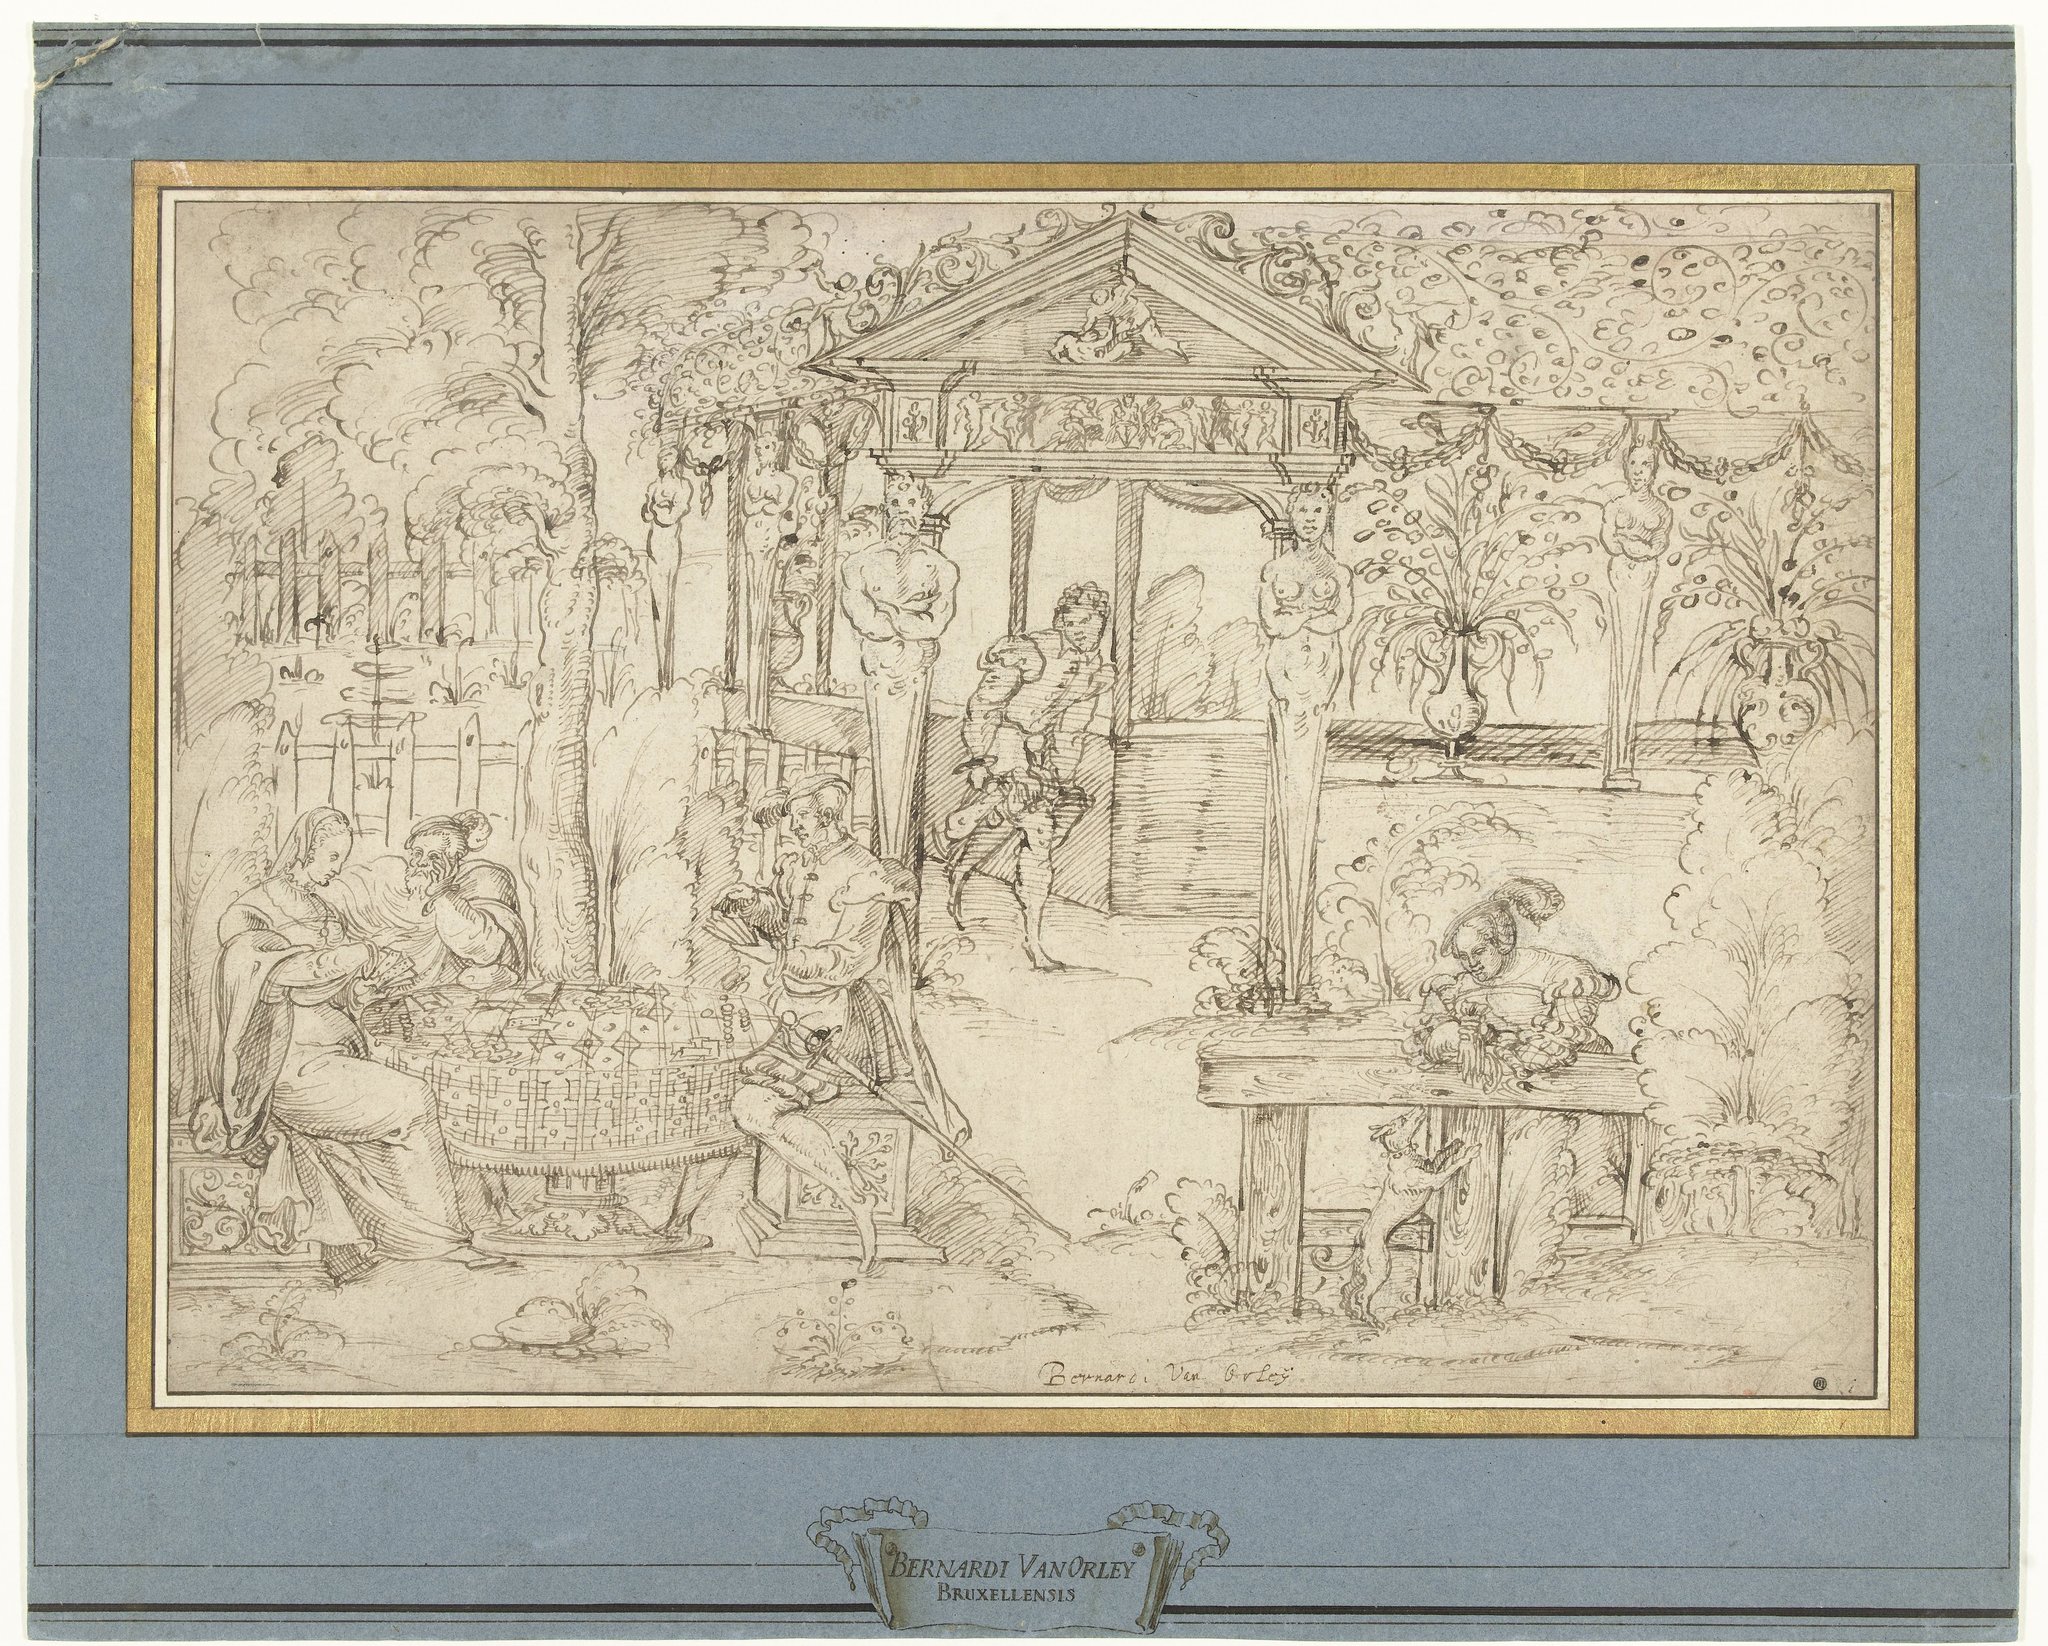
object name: design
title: Twee paren in een tuin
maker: Anonymous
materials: ink, paper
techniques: brush, pen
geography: brussels